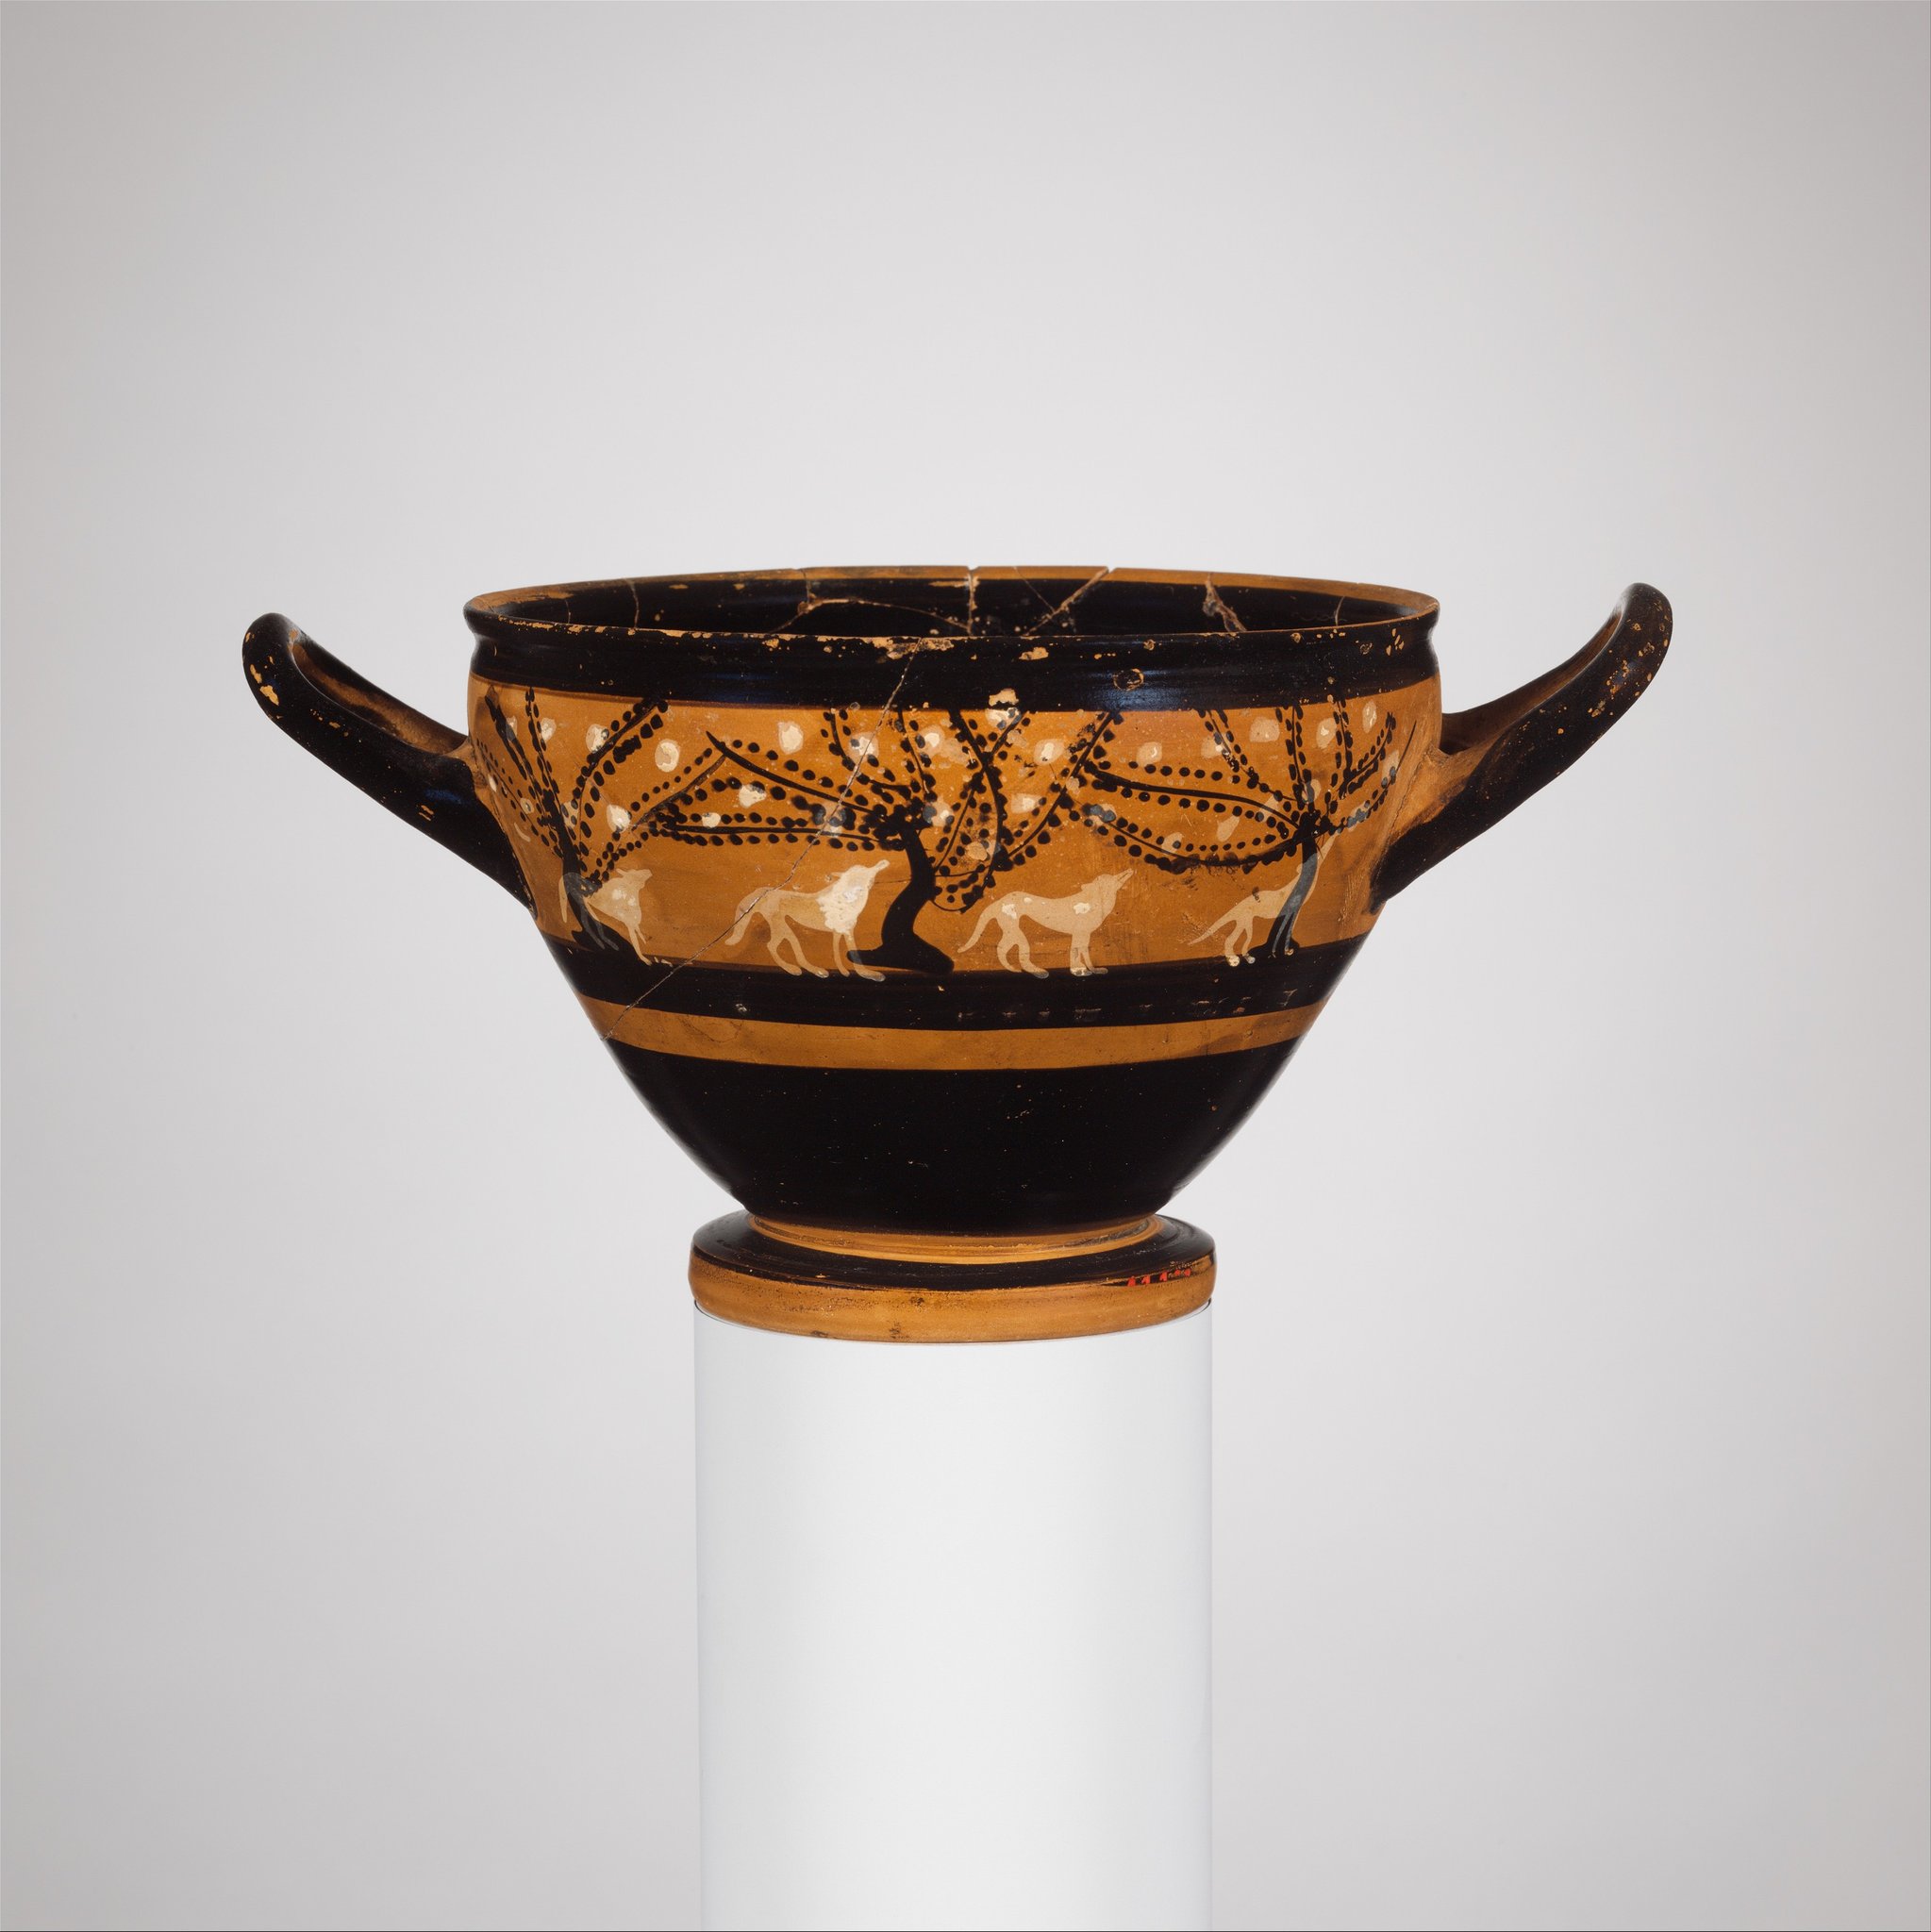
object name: skyphos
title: Terracotta skyphos (deep drinking cup)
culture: greek, attic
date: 500 BCE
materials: terracotta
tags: dogs,trees